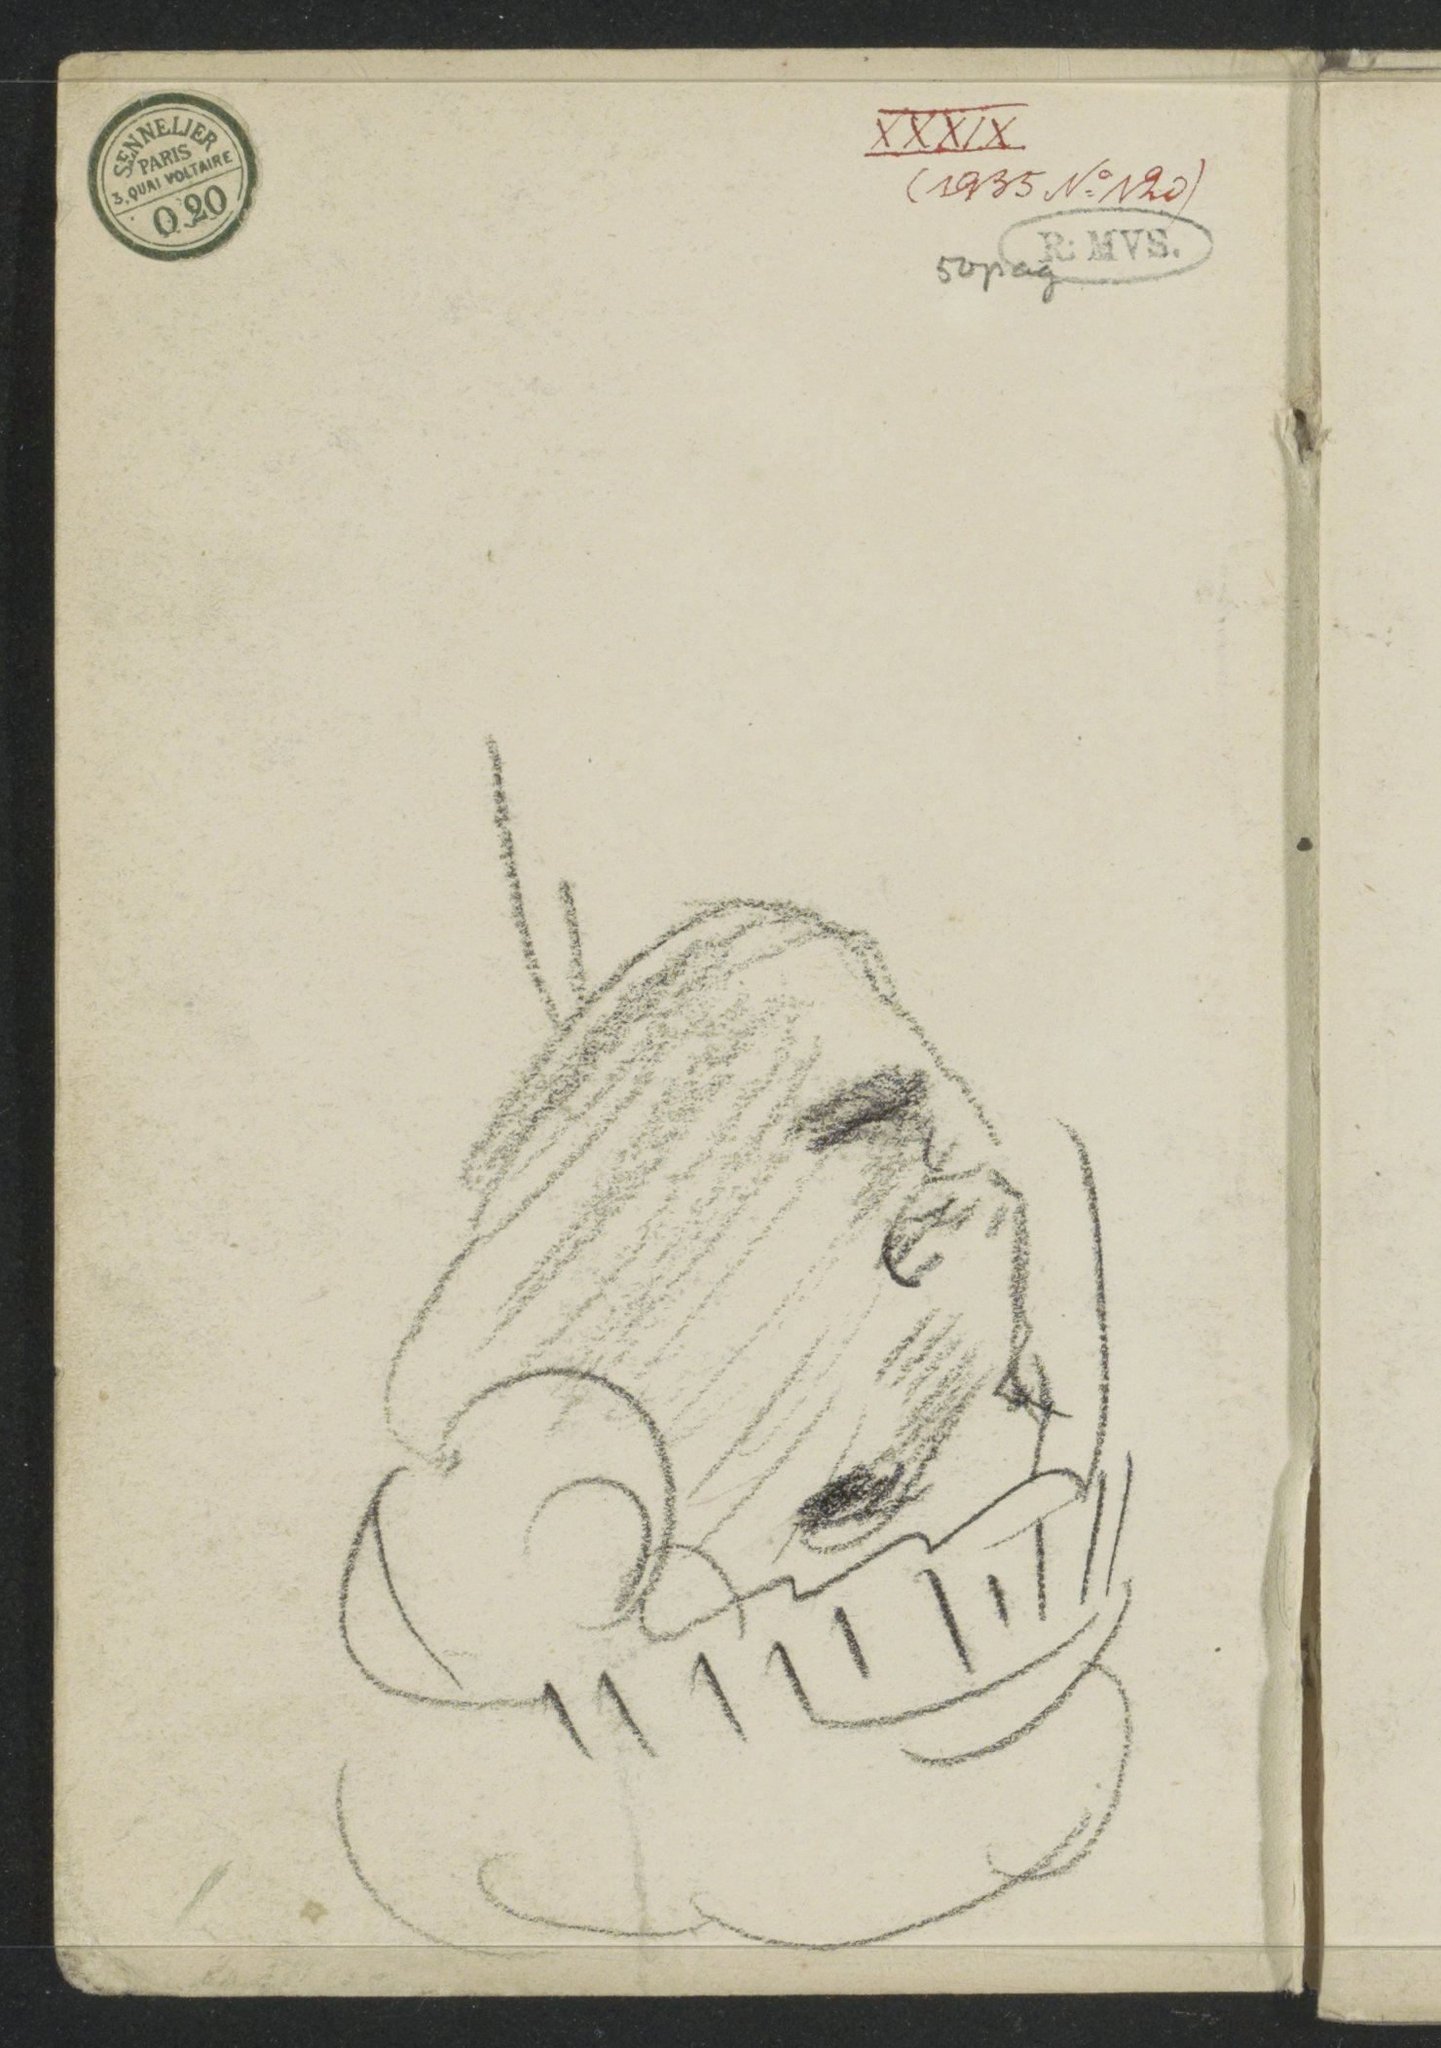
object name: sketchbook leaf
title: Vrouwenhoofd met muts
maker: isaac israels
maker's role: draughtsman, painter, print maker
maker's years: 1865-1934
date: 1887-1934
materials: chalk, paper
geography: paris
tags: head-gear: cap (+ women's clothes), head (human) - aa - female human figure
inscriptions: collector's mark: Lugt 2228, retailer's mark: ‘Sennelier / Paris / 3, Quai Voltaire / 020’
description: Pagina 1, voorste schutblad, uit schetsboek XXXIX met 51 pagina's.